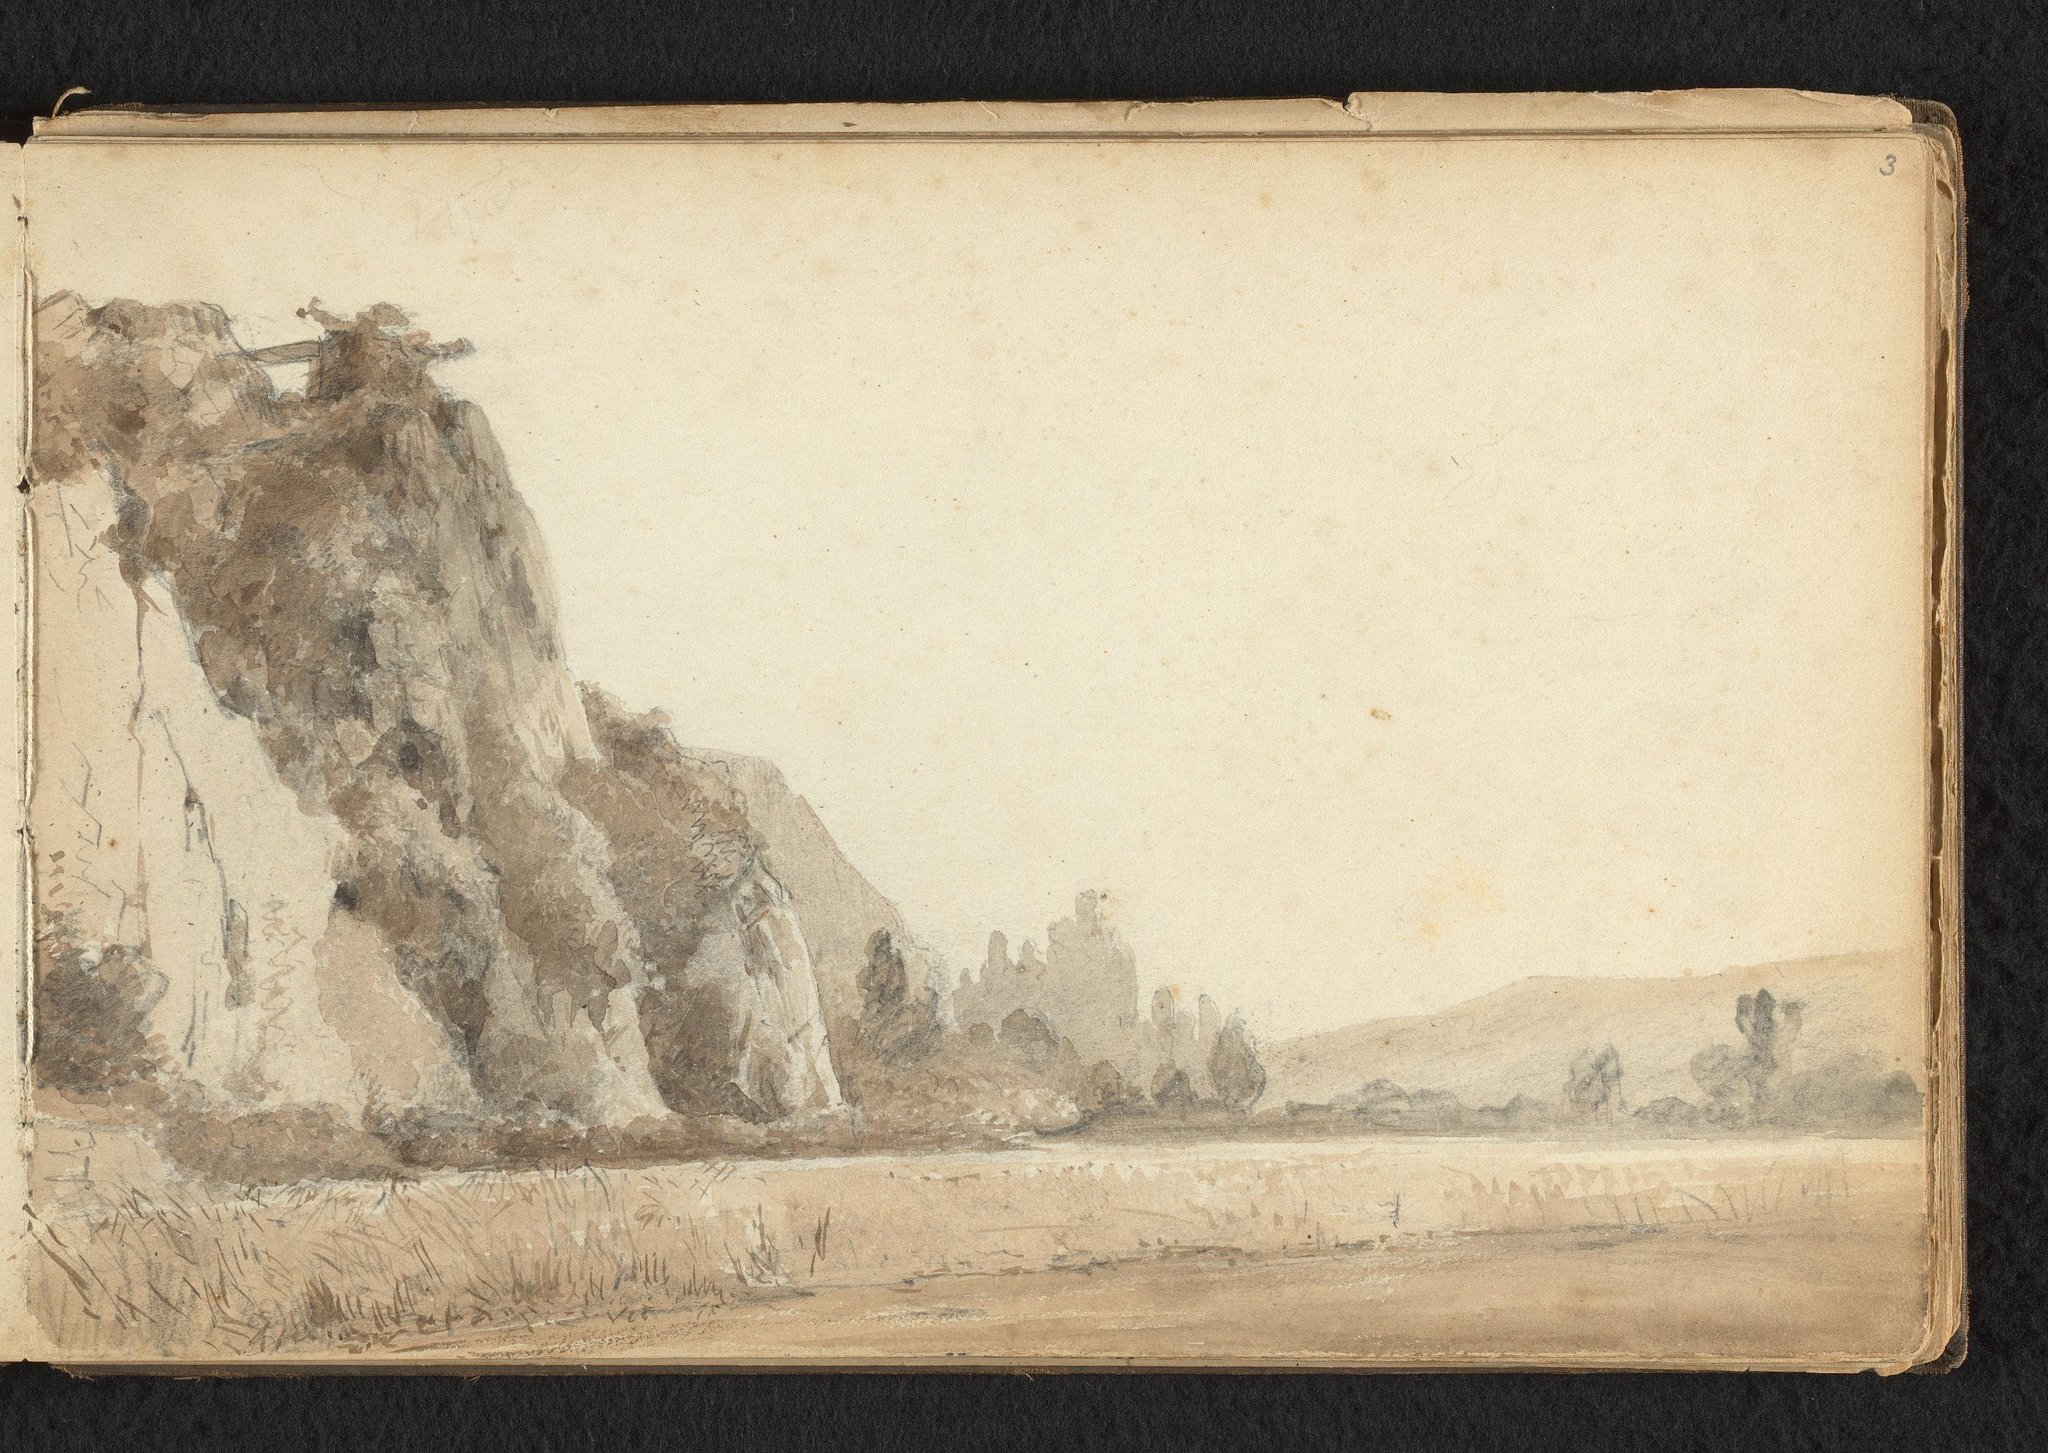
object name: sketchbook leaf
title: Landschap met klif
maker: jan bedijs tom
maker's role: draughtsman, painter, print maker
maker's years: 1813-1894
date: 1823-1894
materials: paper, pencil, watercolor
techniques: brush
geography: the hague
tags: inland cliff face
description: Pagina 3 recto uit een schetsboek met 37 bladen.